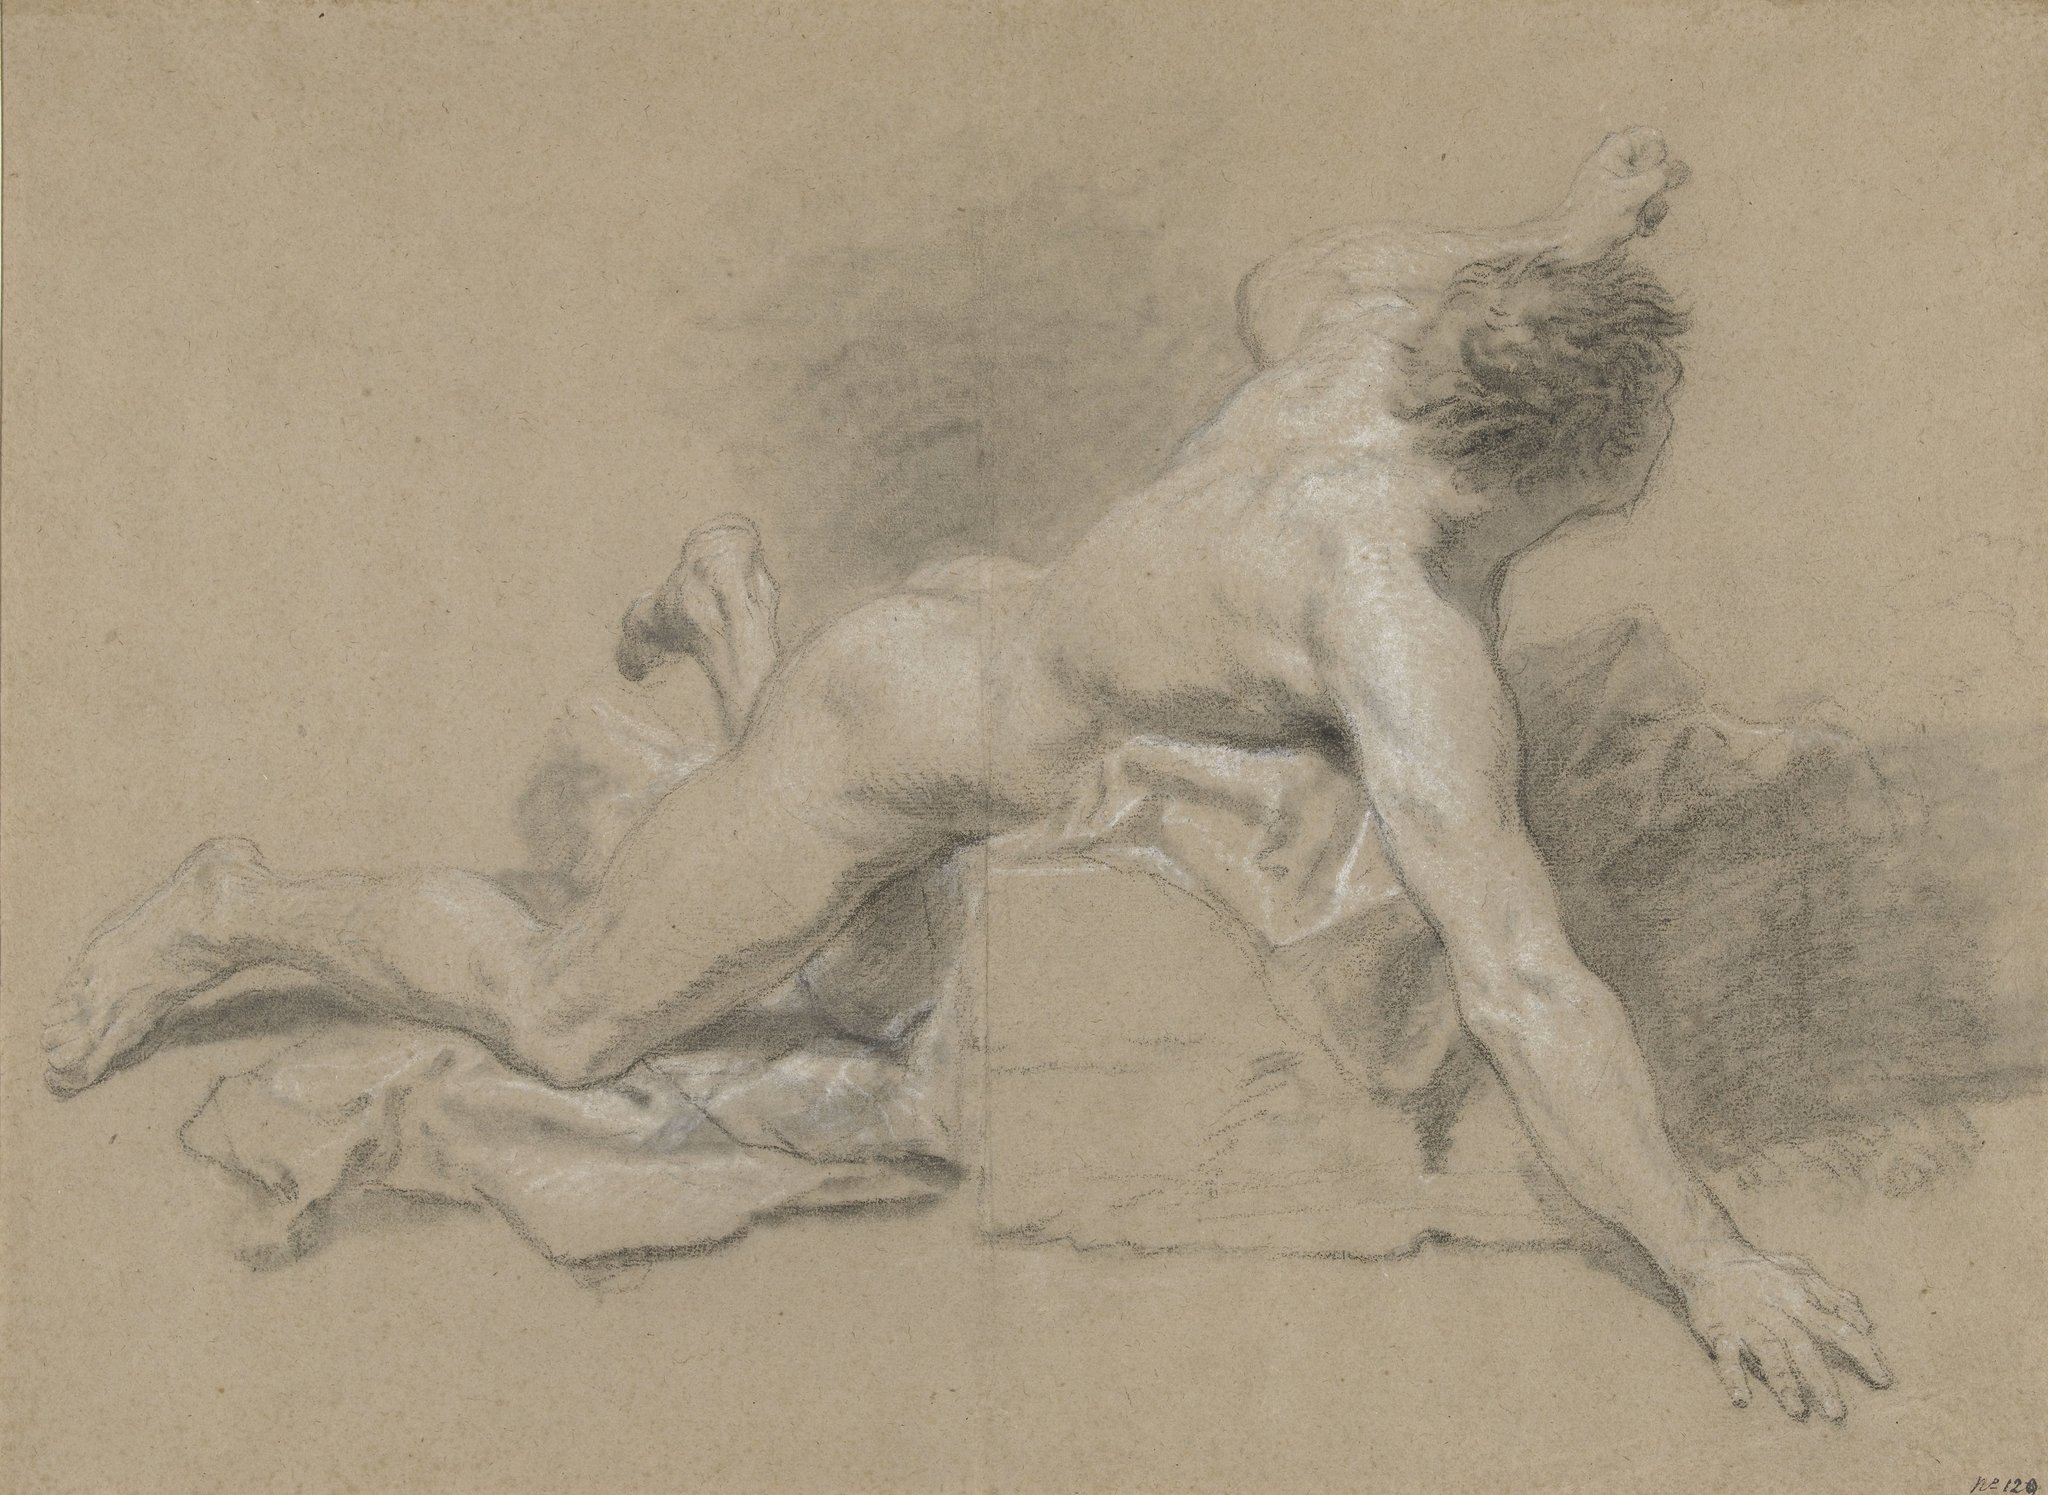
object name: drawing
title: Studie van een mannelijk naakt, liggend op zijn buik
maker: lambertus antonius claessens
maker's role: draughtsman, print maker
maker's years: 1763-1834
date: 1773-1843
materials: chalk, paper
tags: lying figure